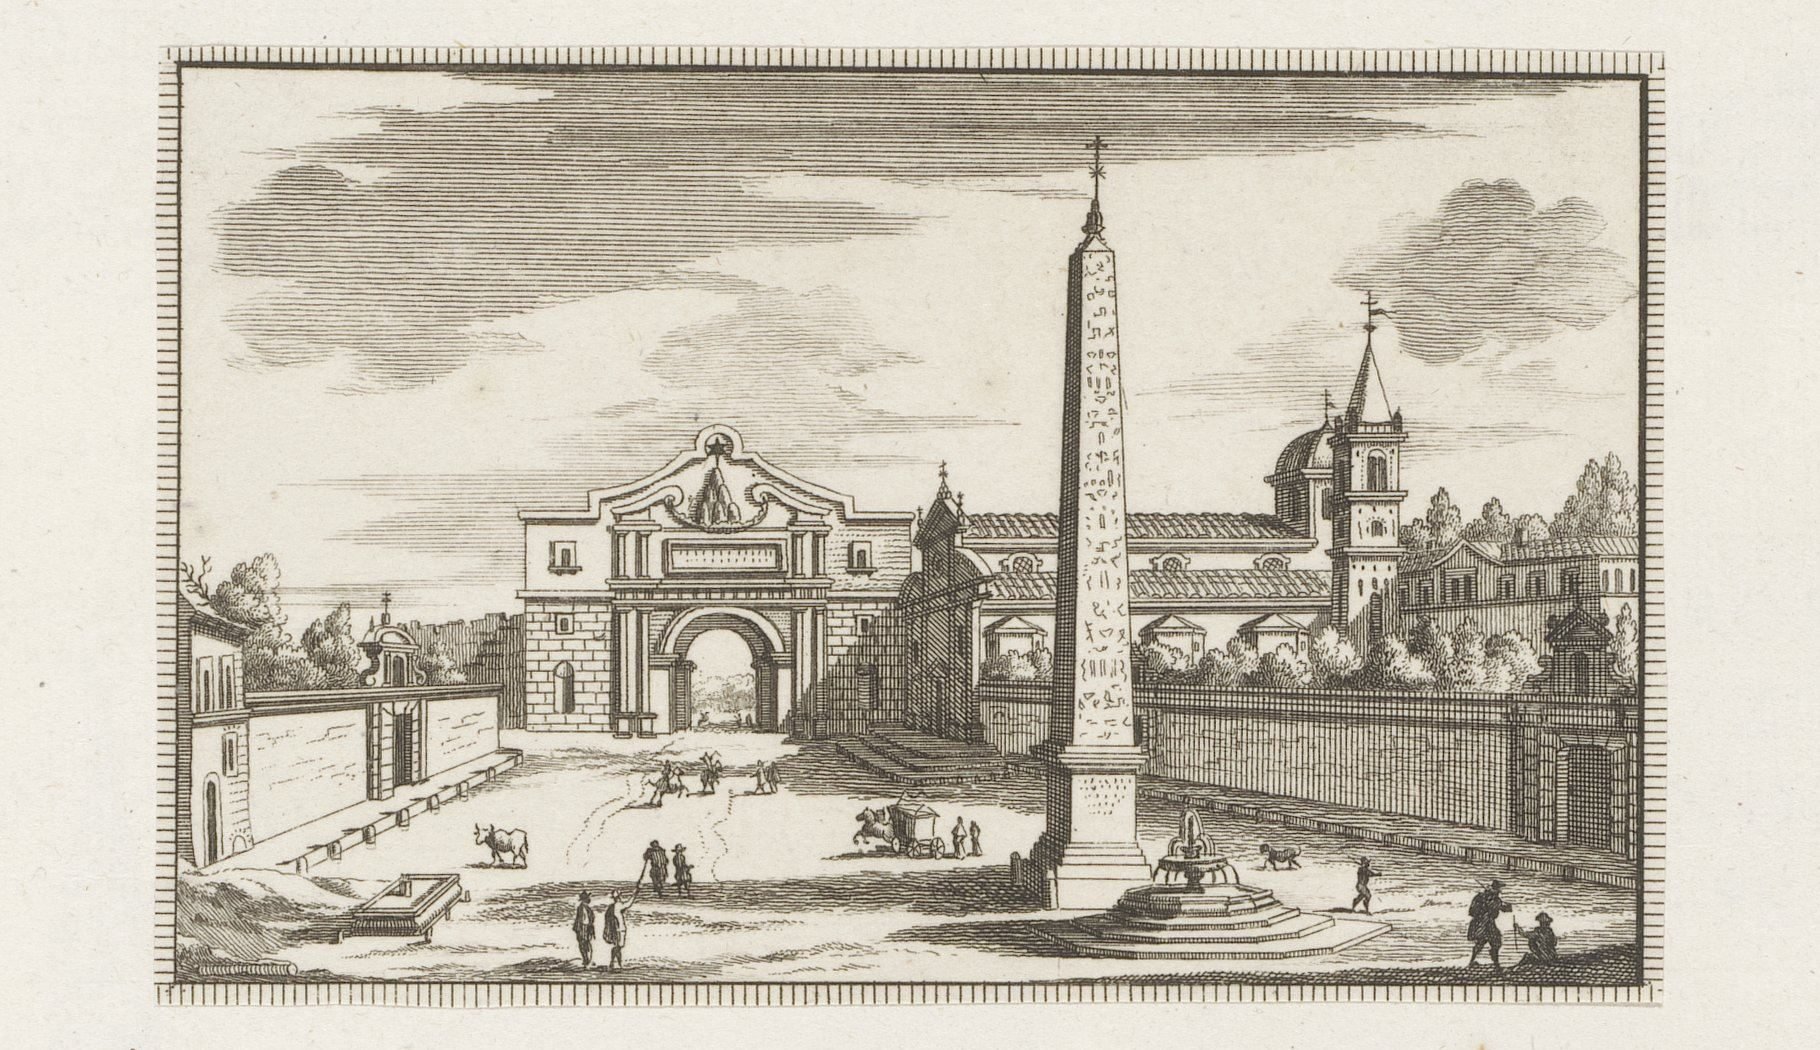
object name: print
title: Gezicht op Piazza del Popolo te Rome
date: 1729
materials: paper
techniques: etching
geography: leiden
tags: square, place, circus, etc., city-view, and landscape with man-made constructions, obelisk, needle, church (exterior)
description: Deze voorstelling is geknipt uit een blad met twee prenten, met in totaal drie voorstellingen. De andere voorstellingen betreffen de Porta Flaminia en de fontein op Piazza del Popolo.